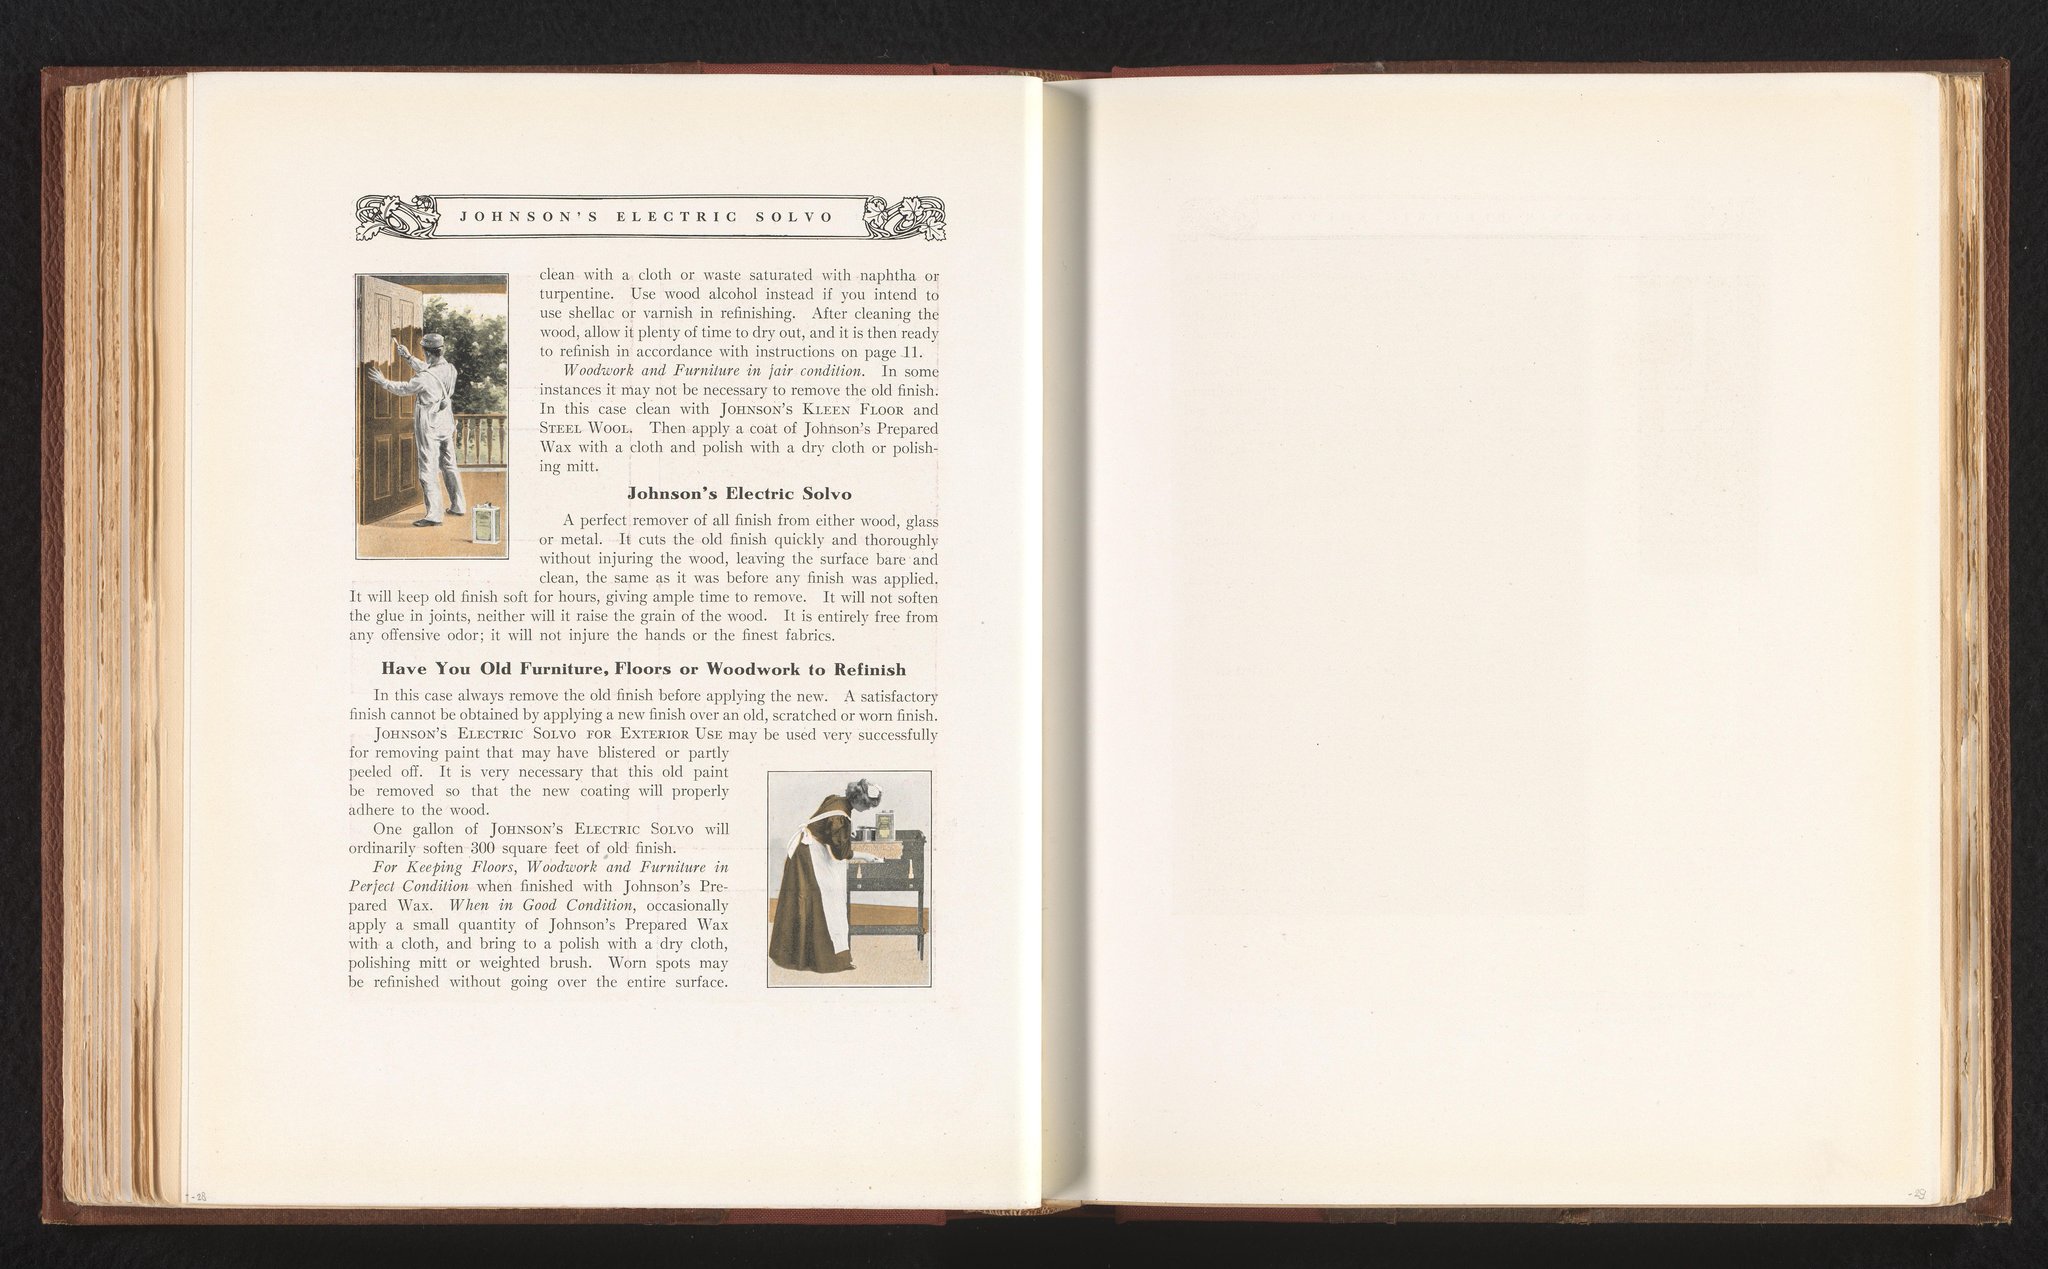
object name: photomechanical print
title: Reclame voor 'Johnson's Electric Solvo', uit de catalogus 'Proper Treatment of Floor, Woodwork and Furniture' gepubliceerd door S.C. Johnson & Son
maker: Anonymous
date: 1904-1909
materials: paper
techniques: autotype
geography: milwaukee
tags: advertising, furniture and household effects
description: Prent op vijfde ongenummerde pagina na pagina 201.